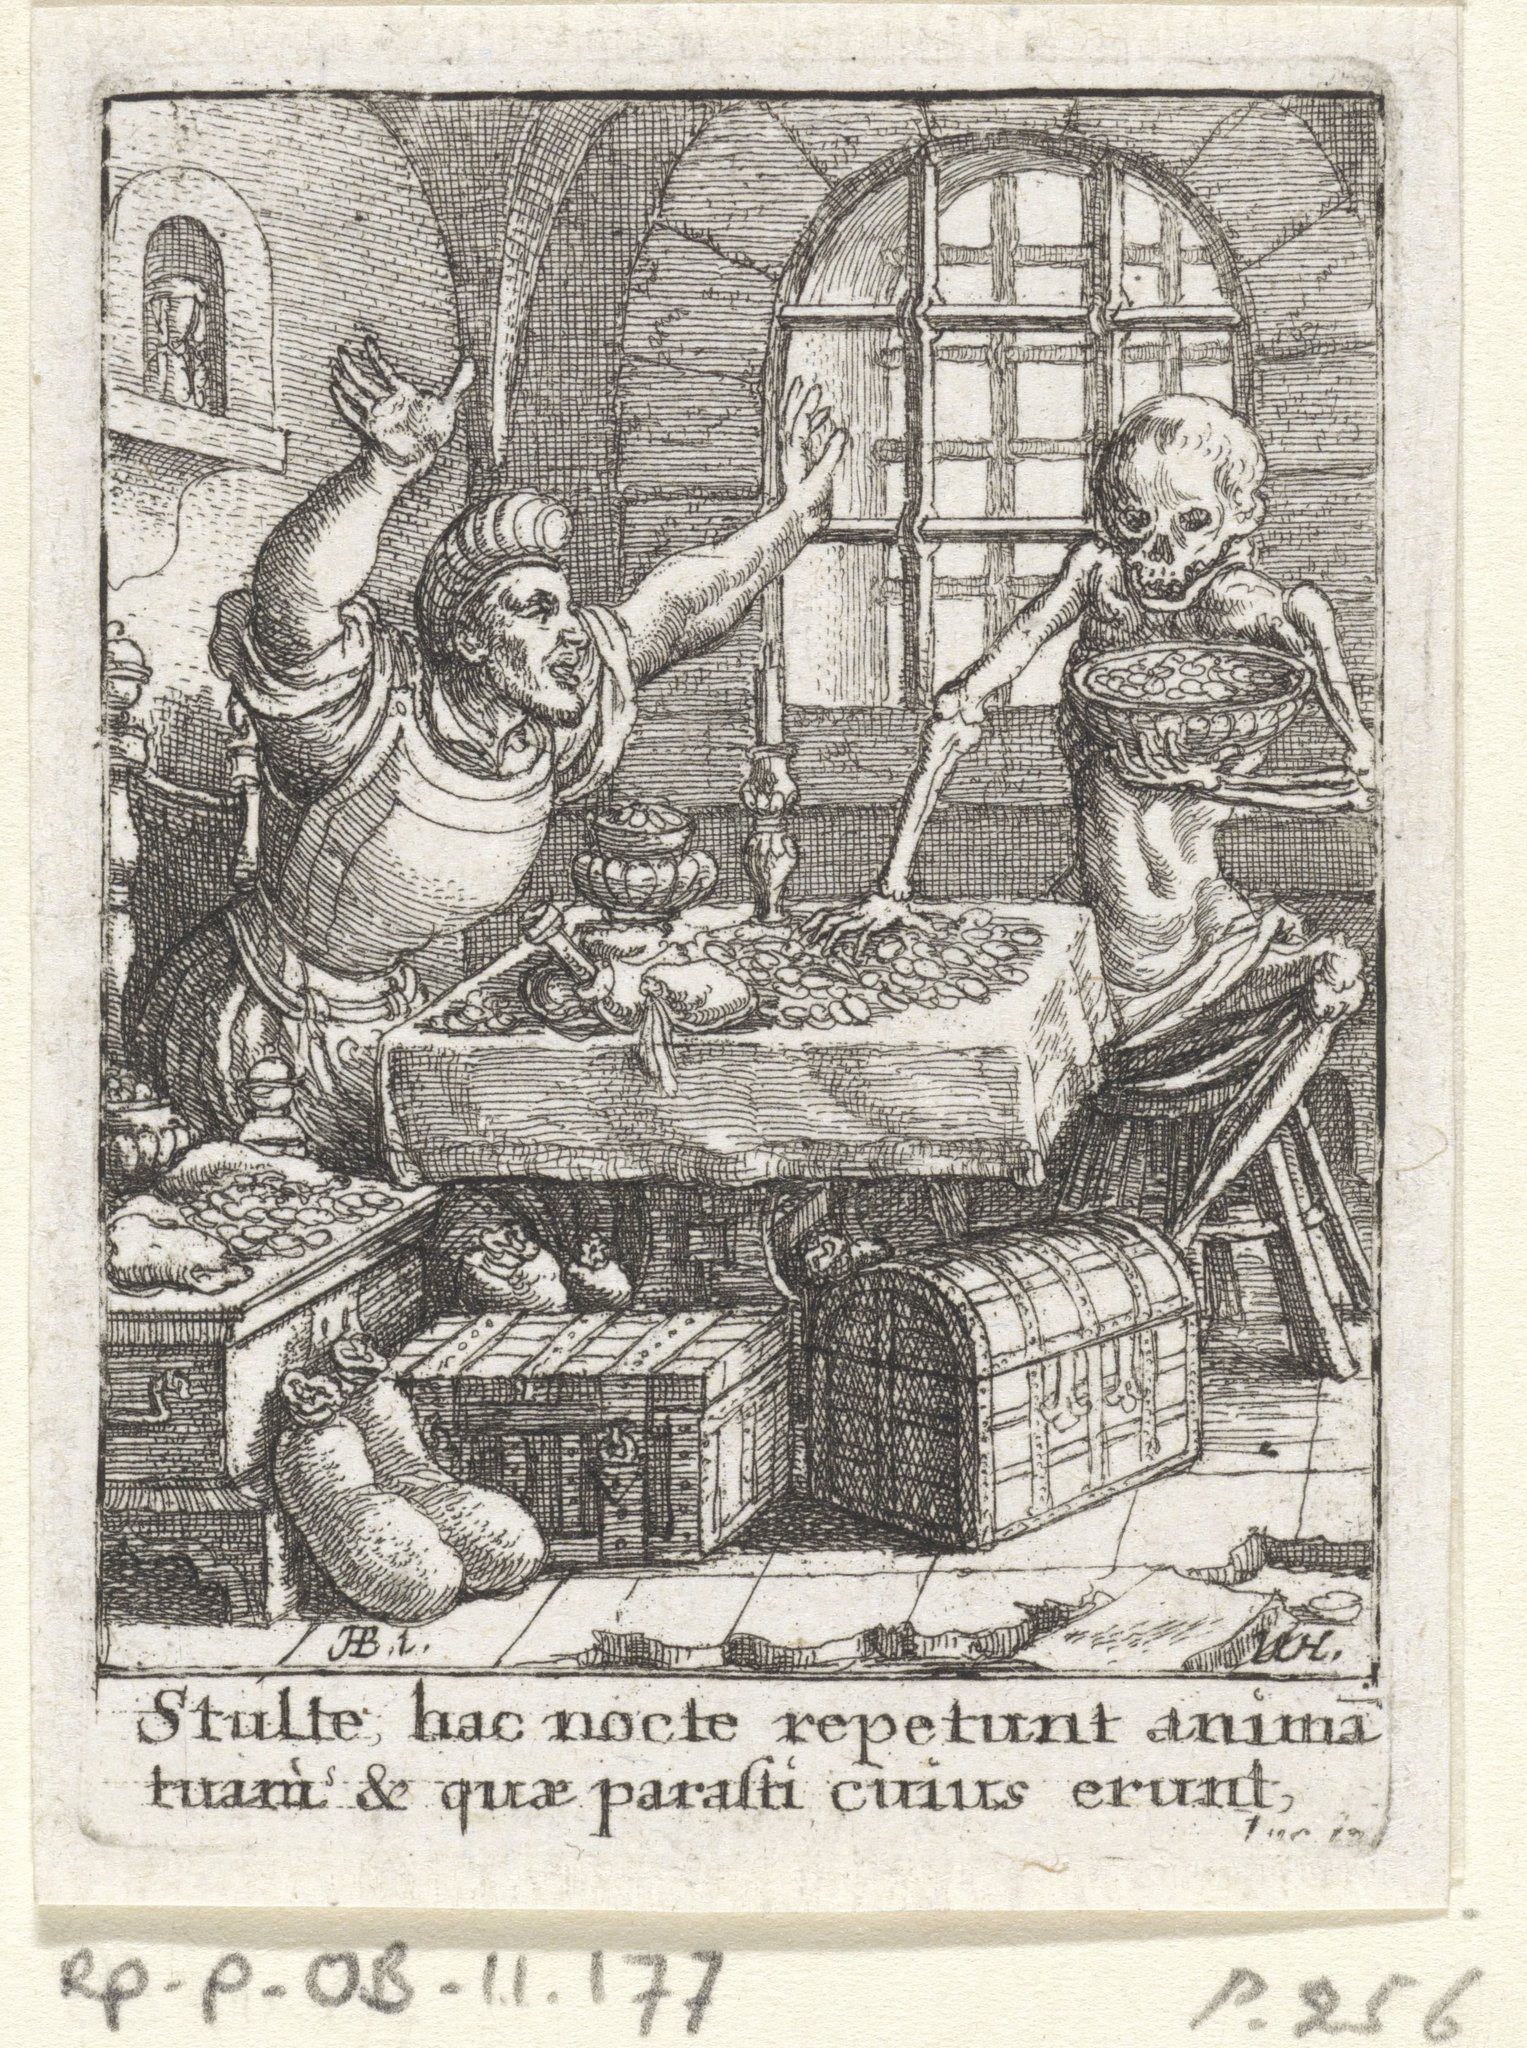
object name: book illustration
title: De rijke man en de Dood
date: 1680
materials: paper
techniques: etching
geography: antwerp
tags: dance of death; death together with one or more human beings, the rich, hourglass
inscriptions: collector's mark: Lugt 240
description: Een rijke man zit aan tafel omringd door kisten en zakken met geld. De Dood pakt munten van tafel en verzamelt ze in een schaal. In een nis in de muur staat een zandloper.